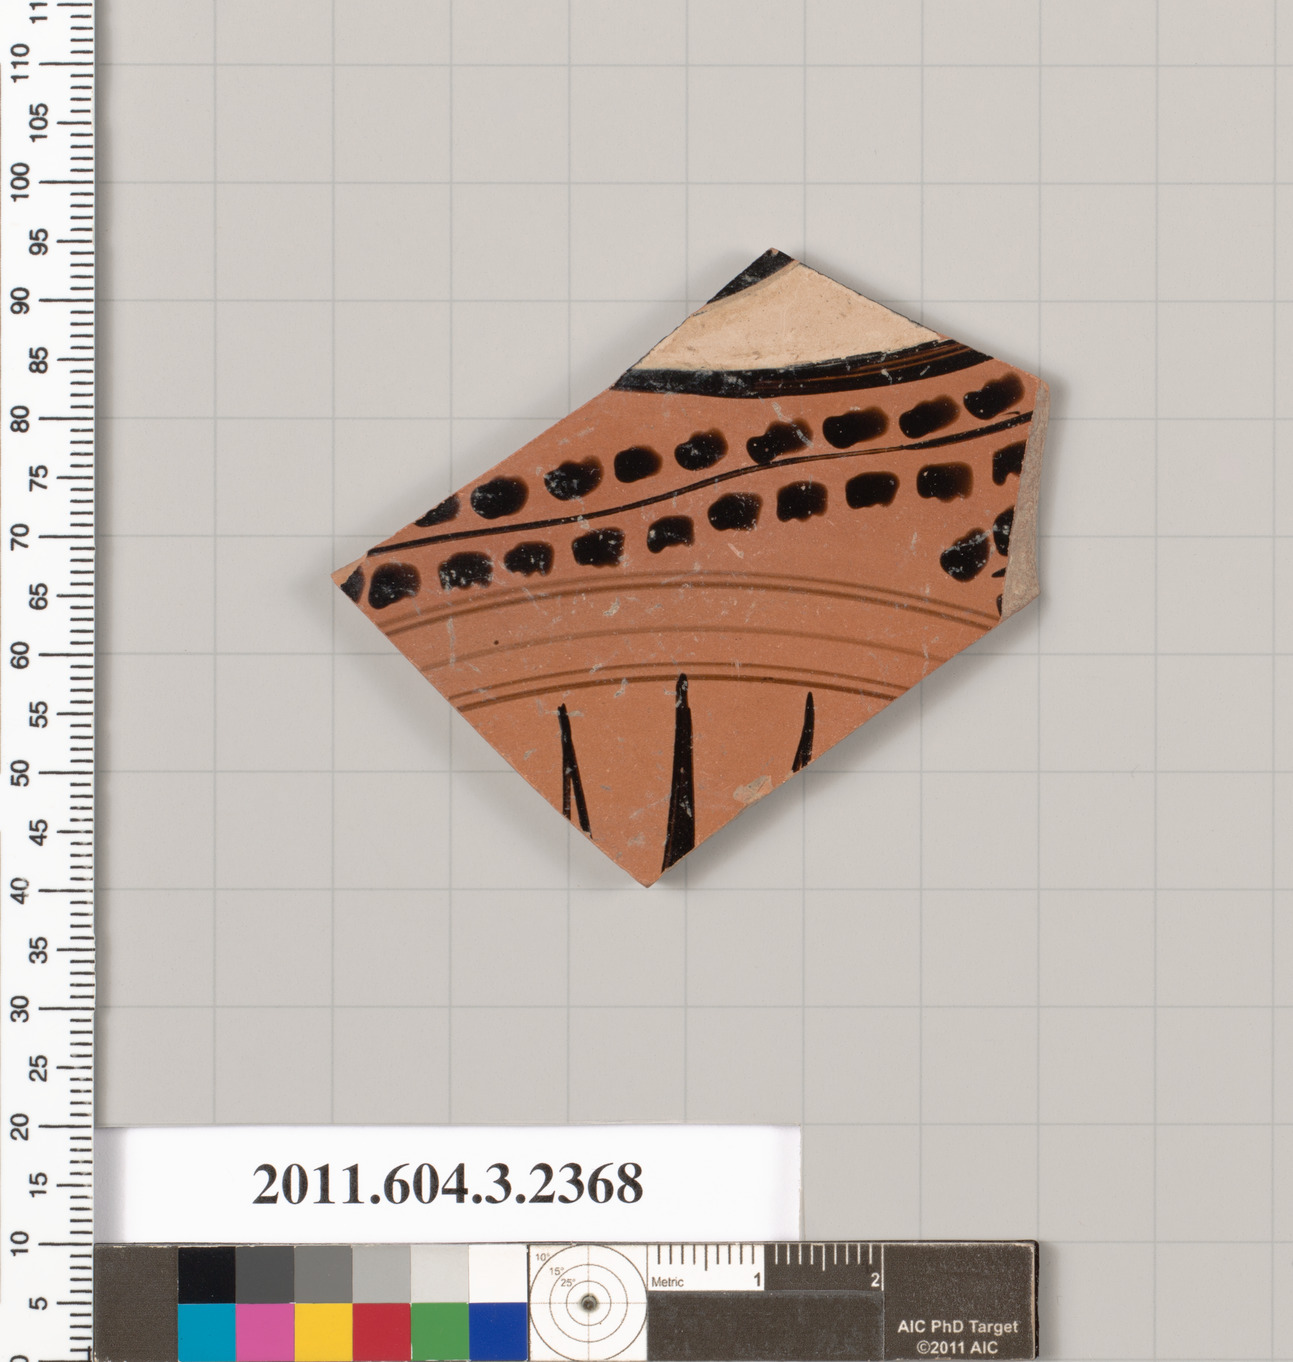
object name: kylix fragment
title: Terracotta fragment of a kylix: eye-cup (drinking cup)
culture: greek, attic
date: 540-520 BCE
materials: terracotta